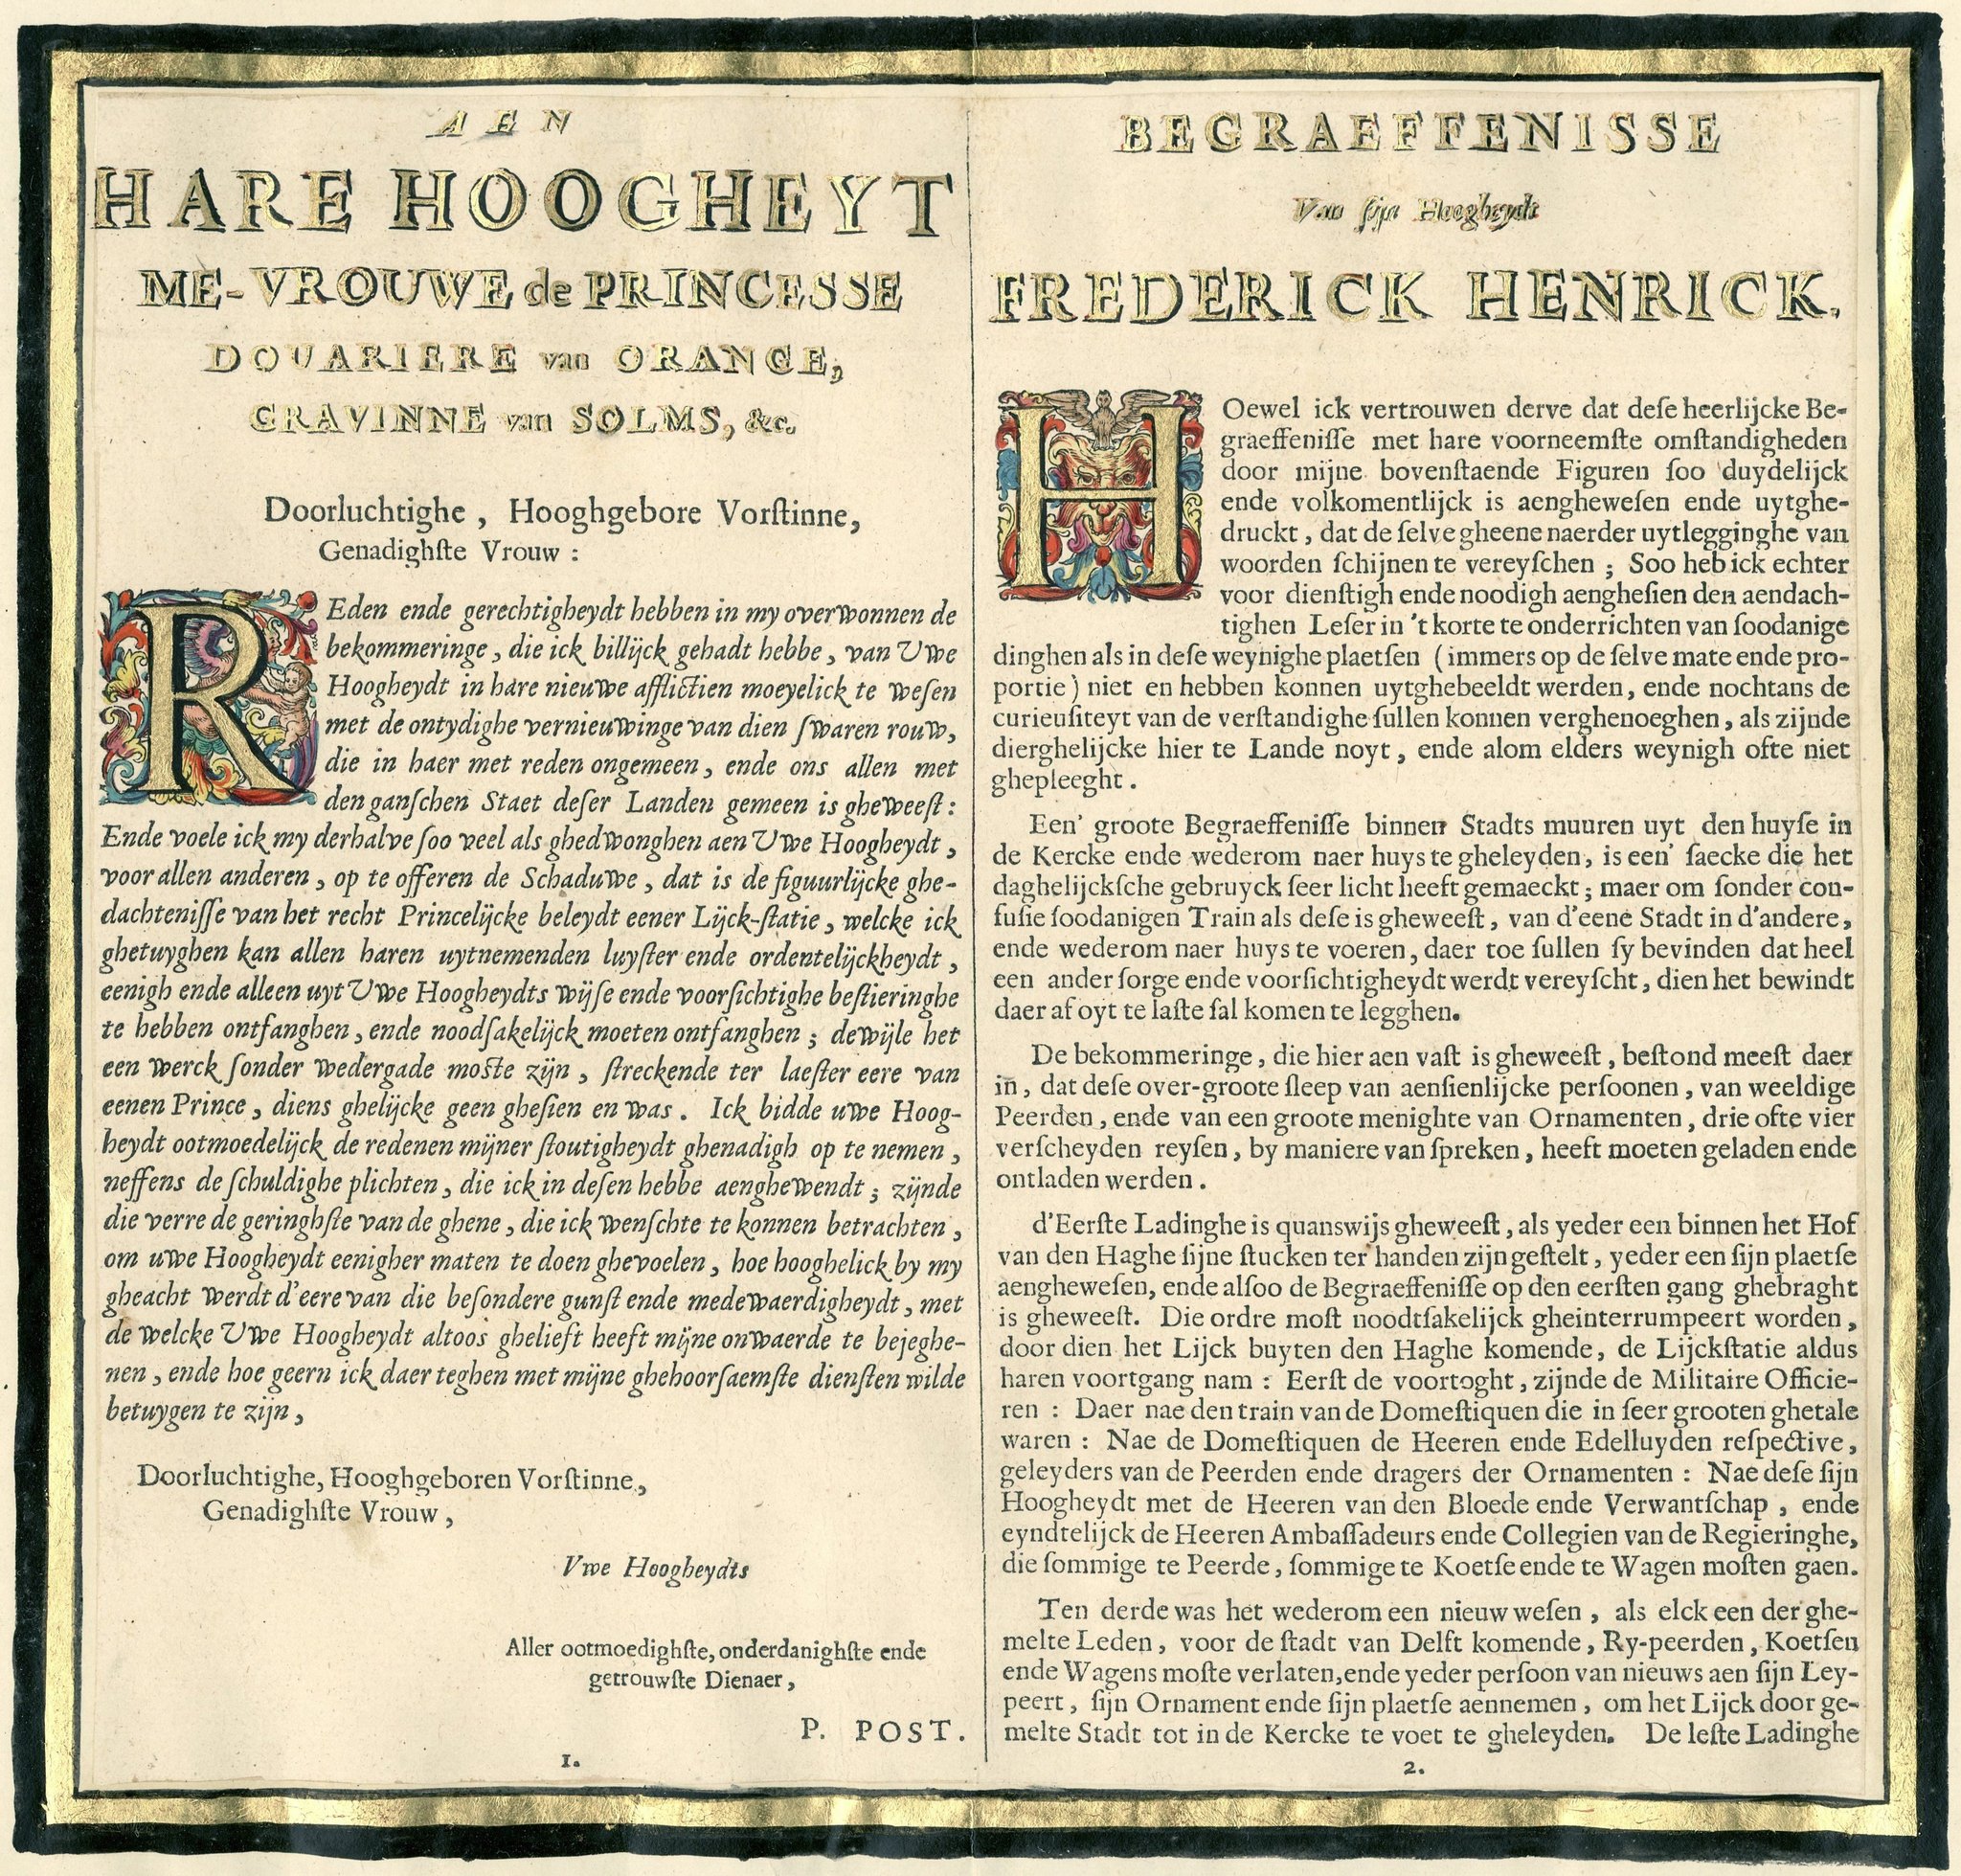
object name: programma, programmaboekje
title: Programma van de begrafenis van Frederik Hendrik, p. 01-02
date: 1651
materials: paint, paper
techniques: colour, letterpress printing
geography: amsterdam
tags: frederick henry (prince of orange), the hague, amalia of solms-braunfels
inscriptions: date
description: Pagina's 1-2 van het programma van de begrafenis van Frederik Hendrik. Voorwoord aan Amalia van Solms, met versierde initialen R en H. Blad uitgeknipt, versierd met goud en ingeplakt in de luxe editie uit ca. 1755 van het boek 'Begraeffenisse van syne hoogheyt Frederick Henrick' van Pieter Post, uitgegeven te Amsterdam in 1651.